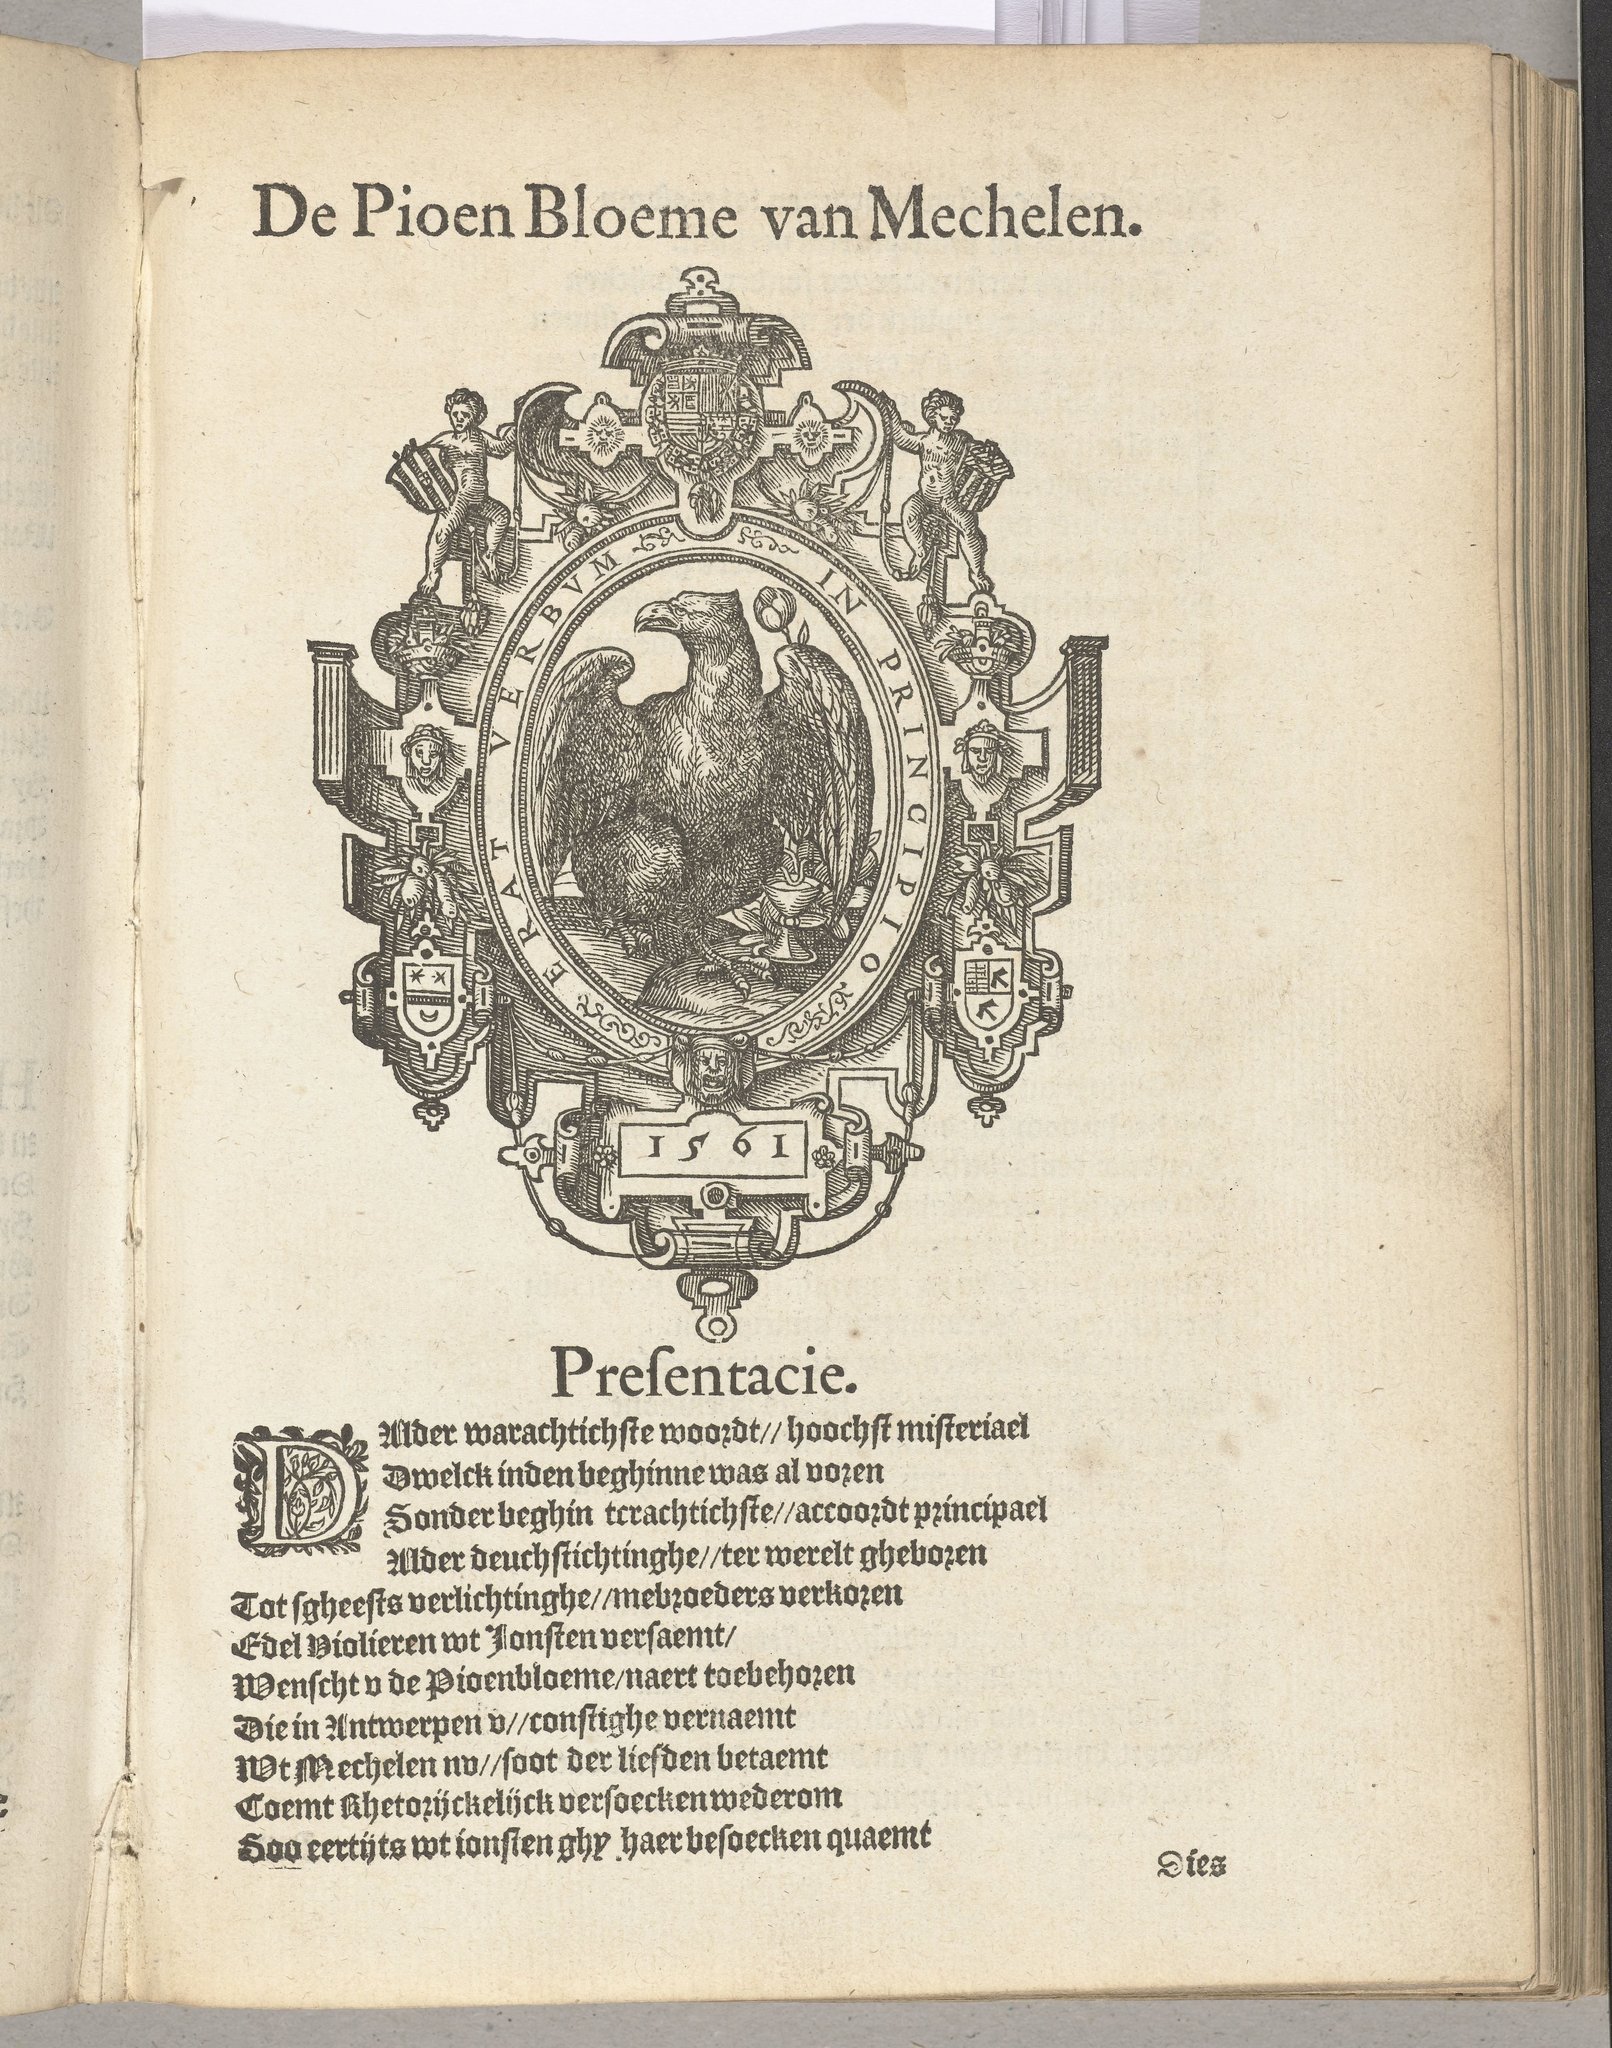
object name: print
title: Vertoning van Het Mariacransken (Brussel), 1561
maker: Anonymous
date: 1561-1562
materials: paper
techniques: woodcut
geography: antwerp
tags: theatre, theatrical performance, chamber of rhetoric (dutch: 'rederijkerskamer'), antwerp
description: Illustratie in: Spelen van sinne vol scoone moralisacien wtleggingen ende bediedenissen op alle loeflijcke consten waer inne men claerlijck ghelijck in eene spieghel, figuerlijck, poetelijck en retorijckelijck mach aenschouwen hoe nootsakelijck ende dienstelijck die selve consten allen menschen zijn : ghespeelt met octroy der Con. Ma. binnen der stadt van Andtwerpen op dLant-Juweel by die veerthien cameren van Retorijcken die hen daer ghepresenteert hebben den derden dach Augusti int Jaer ons Heeren 1561, op die questie : wat den mensch aldermeest tot conste verwect. Uitgave van 1562, p. Bbb (3). In het exemplaar in de Rijksmuseum Research Library, signatuur: 325 D 20.